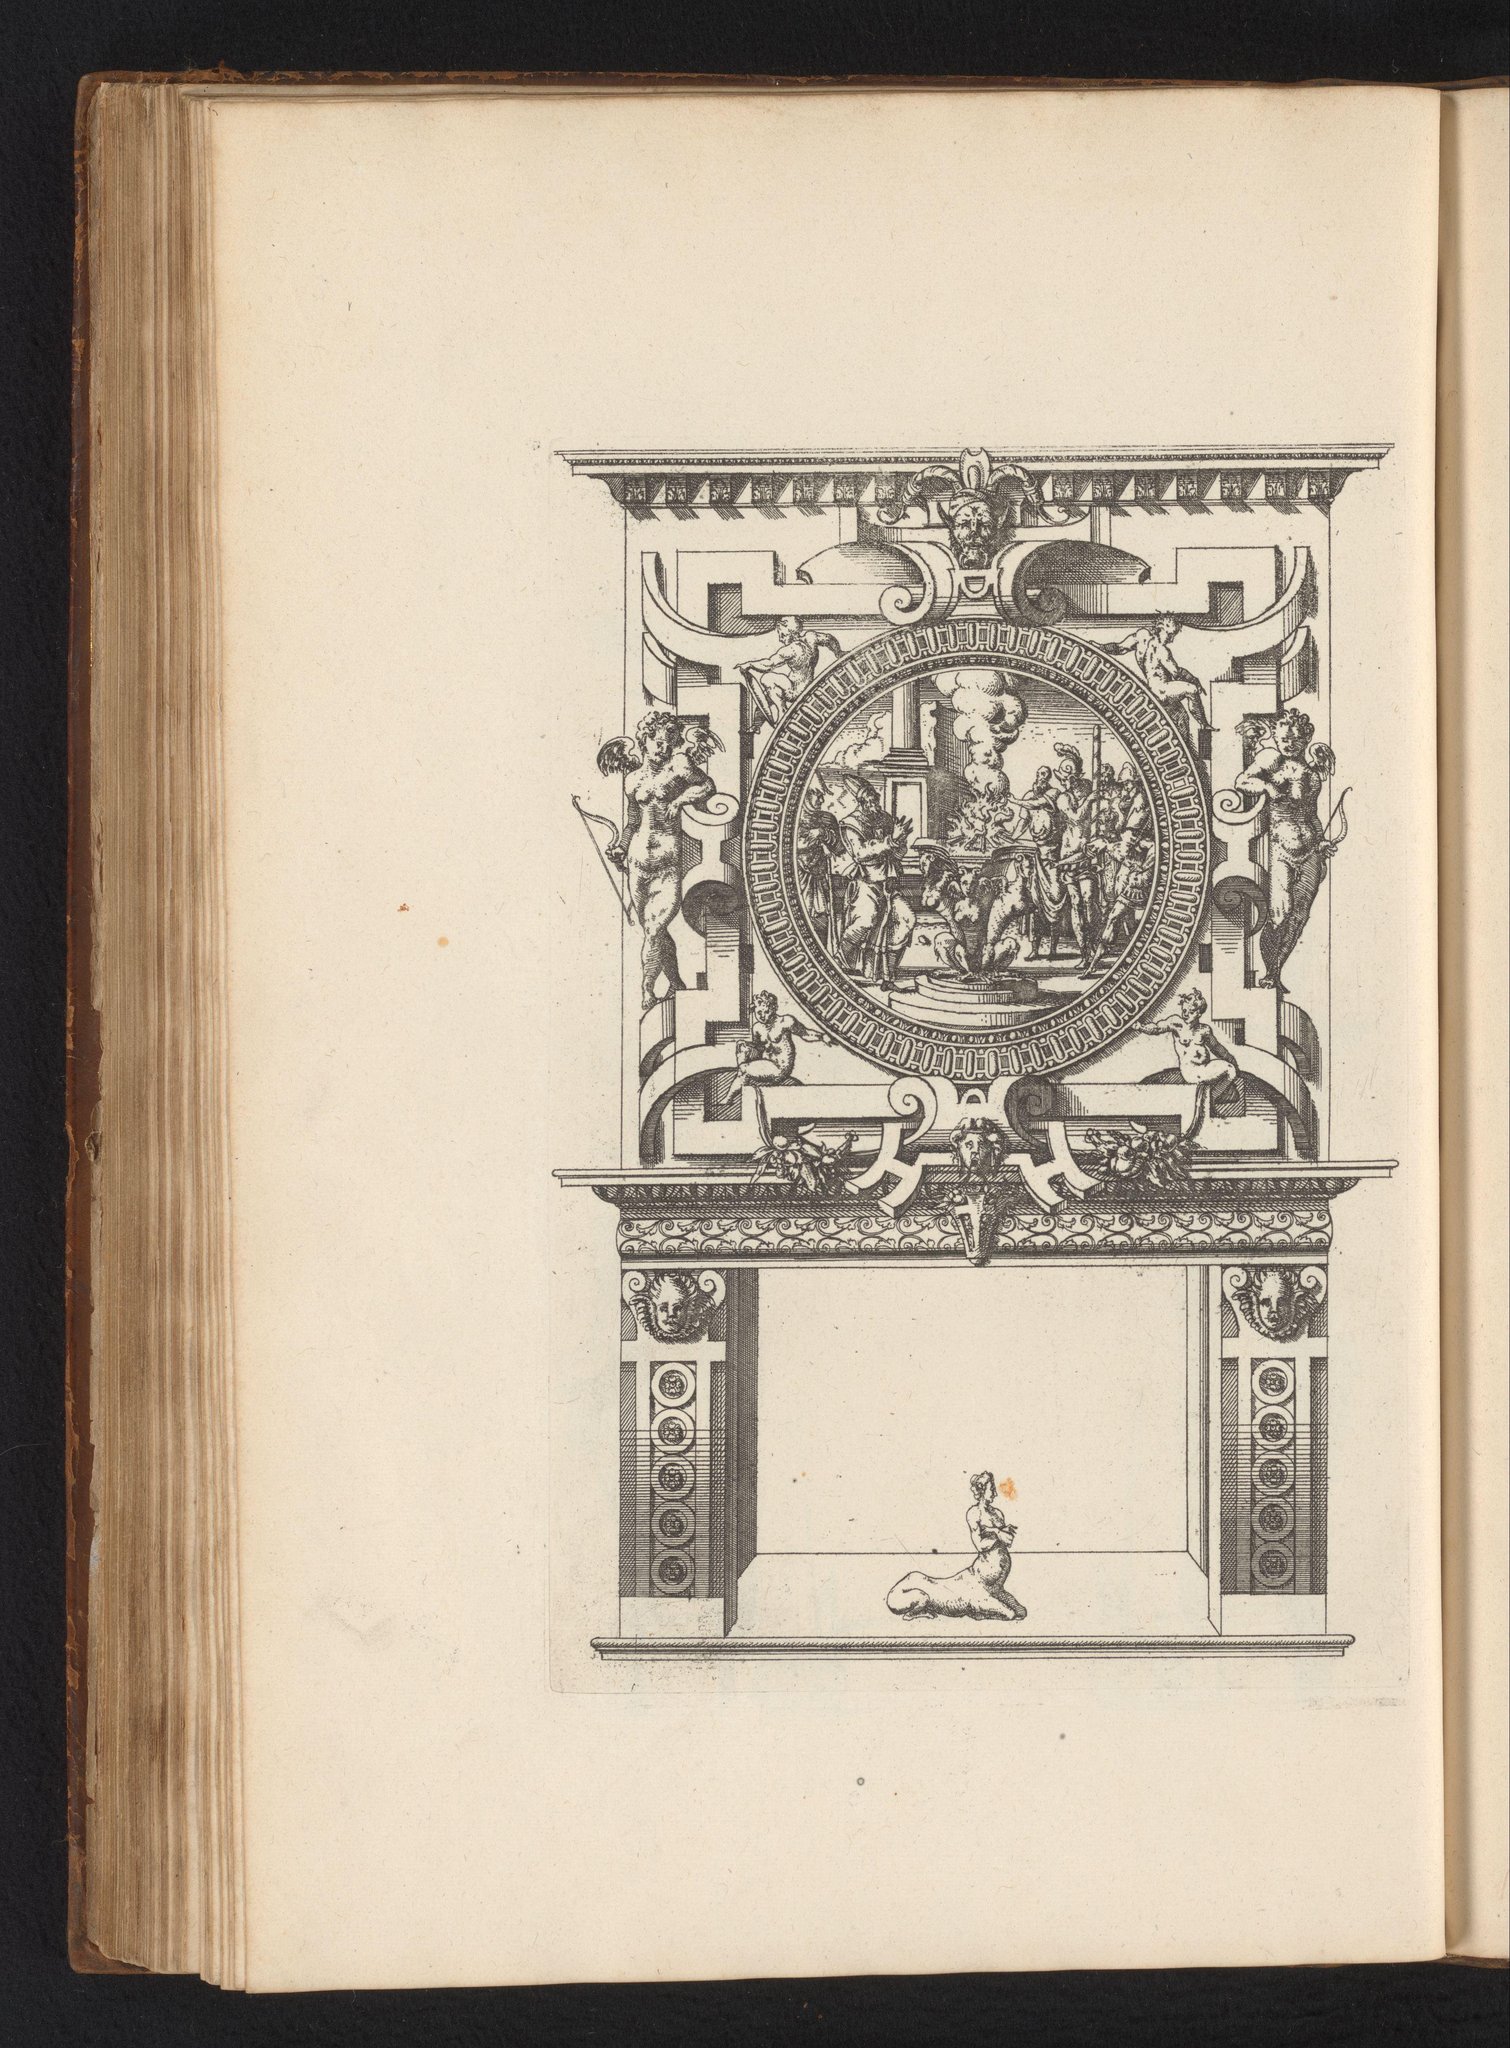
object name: ornament print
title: Schoorsteenmantel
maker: jacques androuet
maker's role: draughtsman, print maker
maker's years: 1515-1584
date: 1561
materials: paper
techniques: etching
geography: paris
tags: architectural design or model, chimney-piece, mantelpiece, sacrifice ~ roman religion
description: Schoorsteenmantel met op de schouw een medaillon met een offerscène. Onderdeel van 'Seconde livre d'architectvre' (1561): 64 etsen met geornamenteerde architectuuronderdelen.